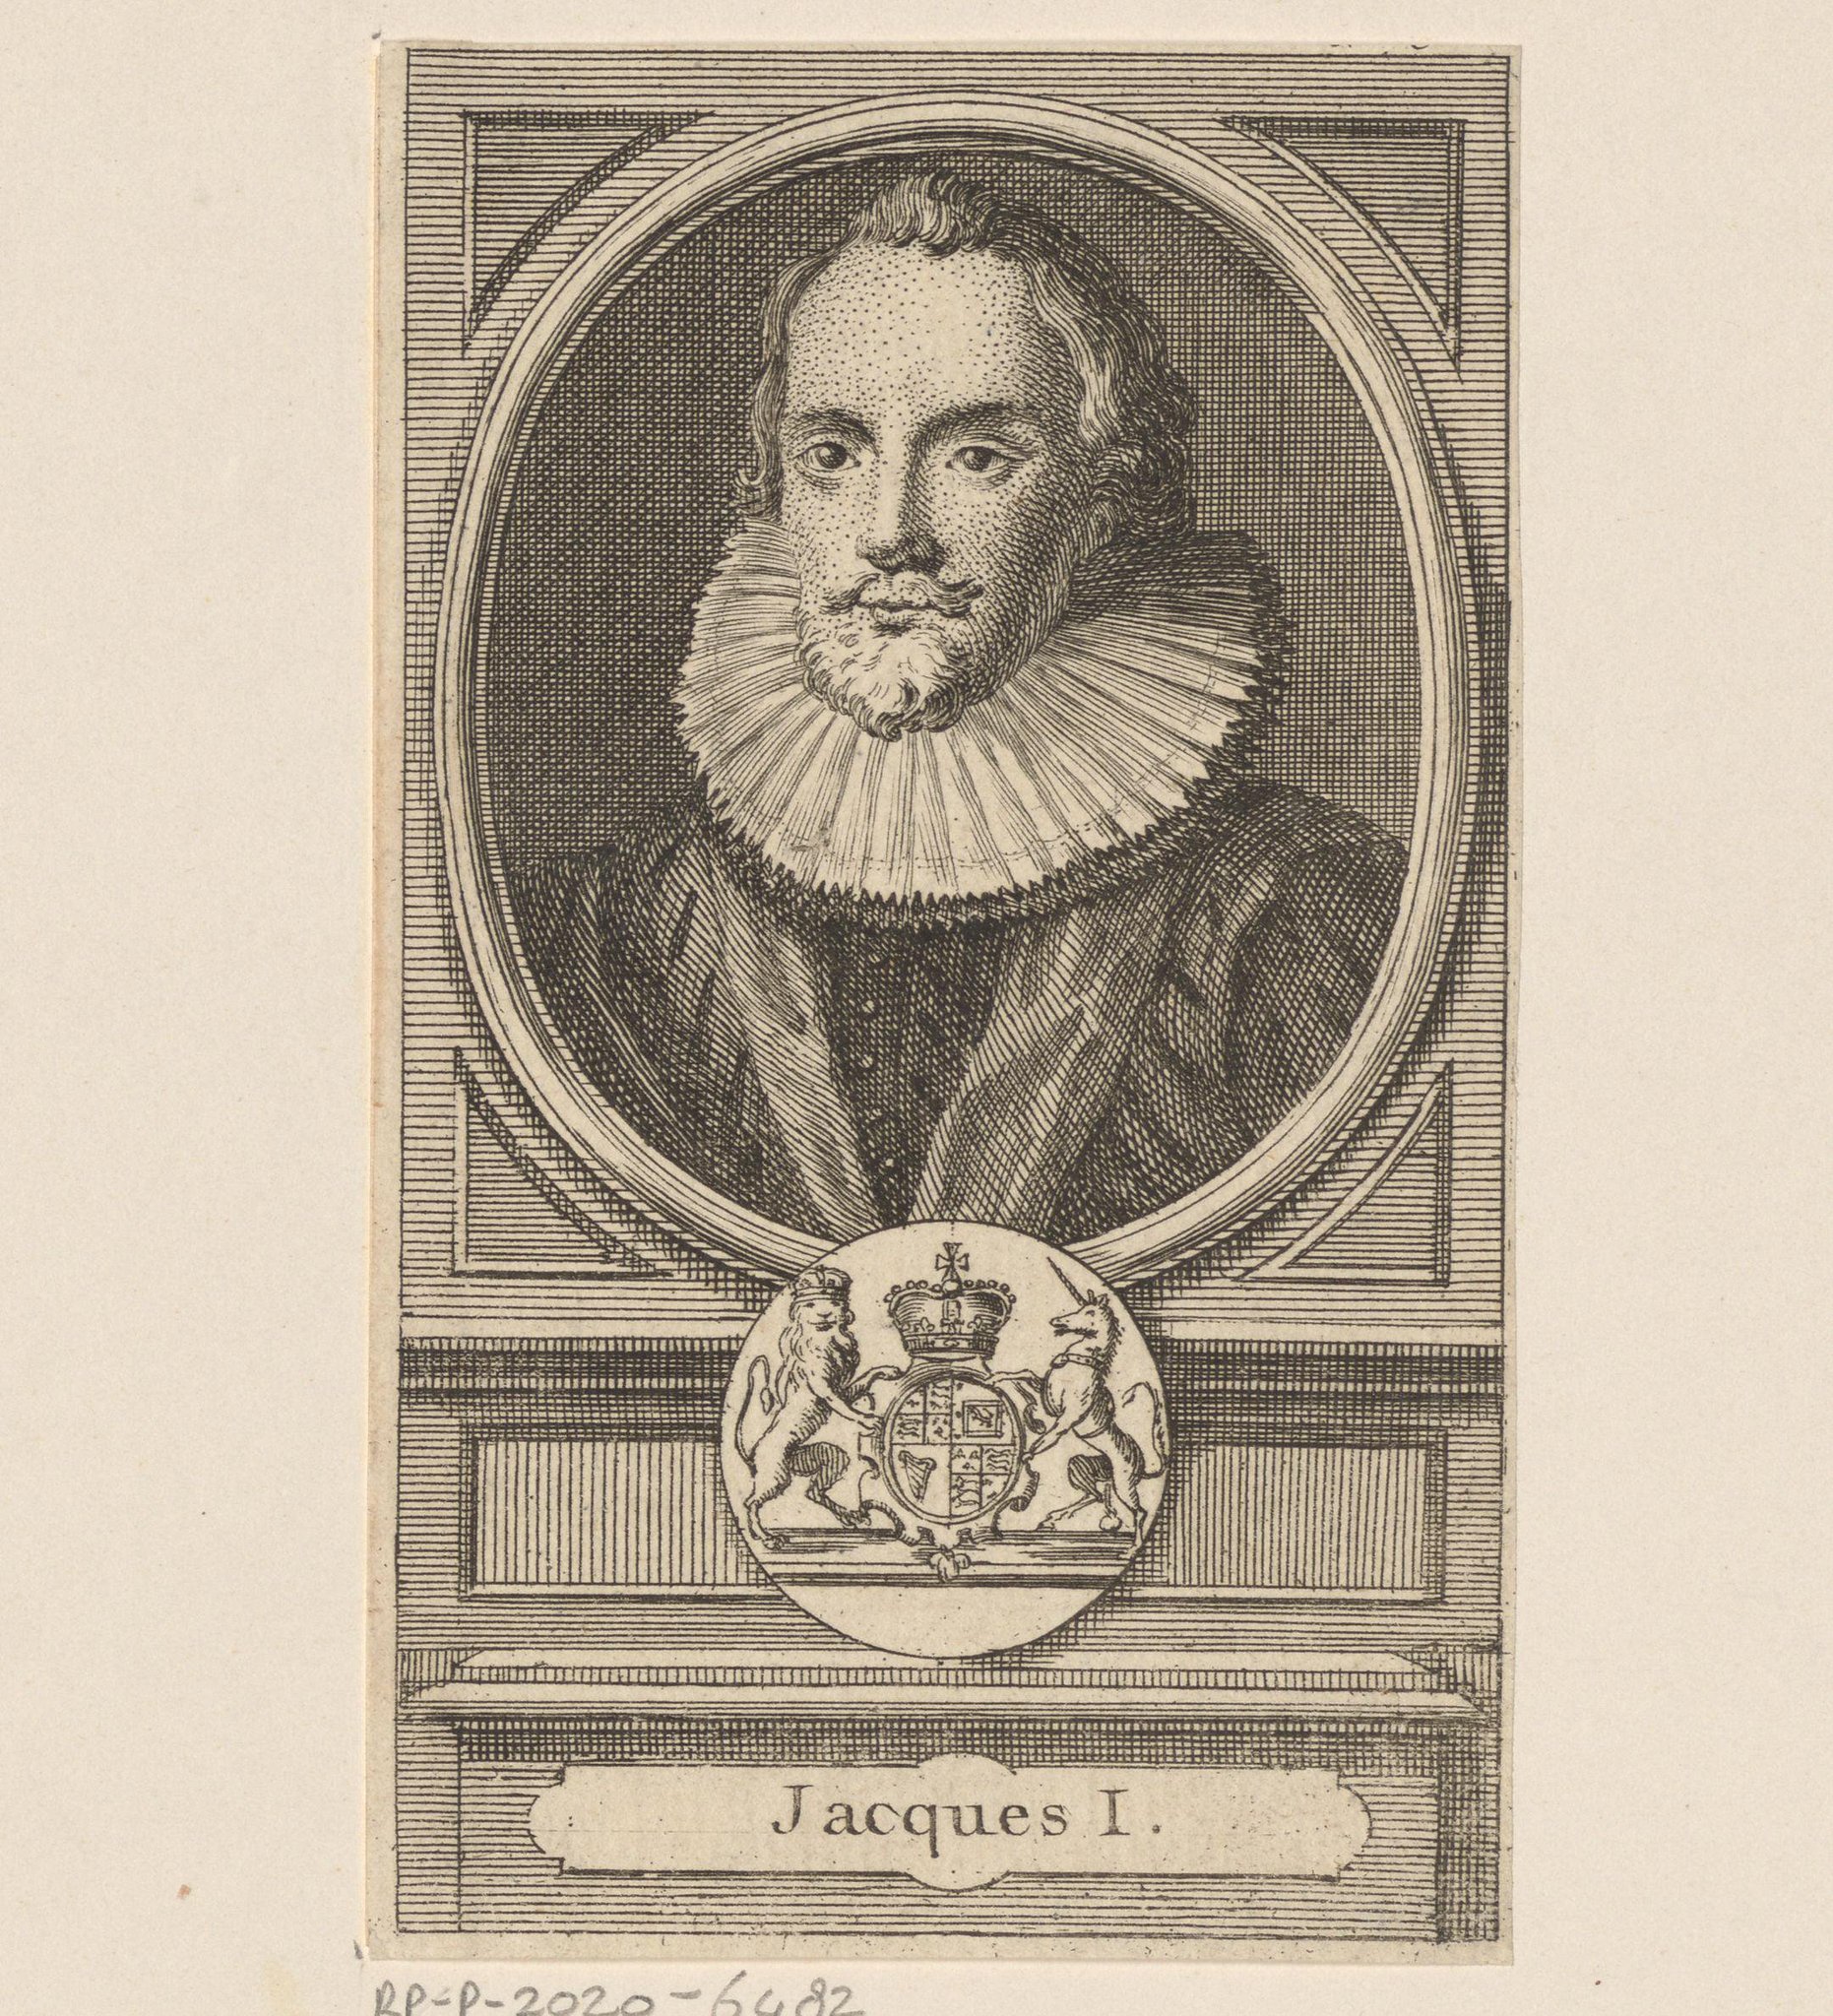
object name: print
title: Portret van Jacobus I, koning van Engeland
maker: Anonymous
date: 1700-1799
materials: paper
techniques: engraving, etching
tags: jacobus i (koning van engeland), historical persons, king, armorial bearing, heraldry